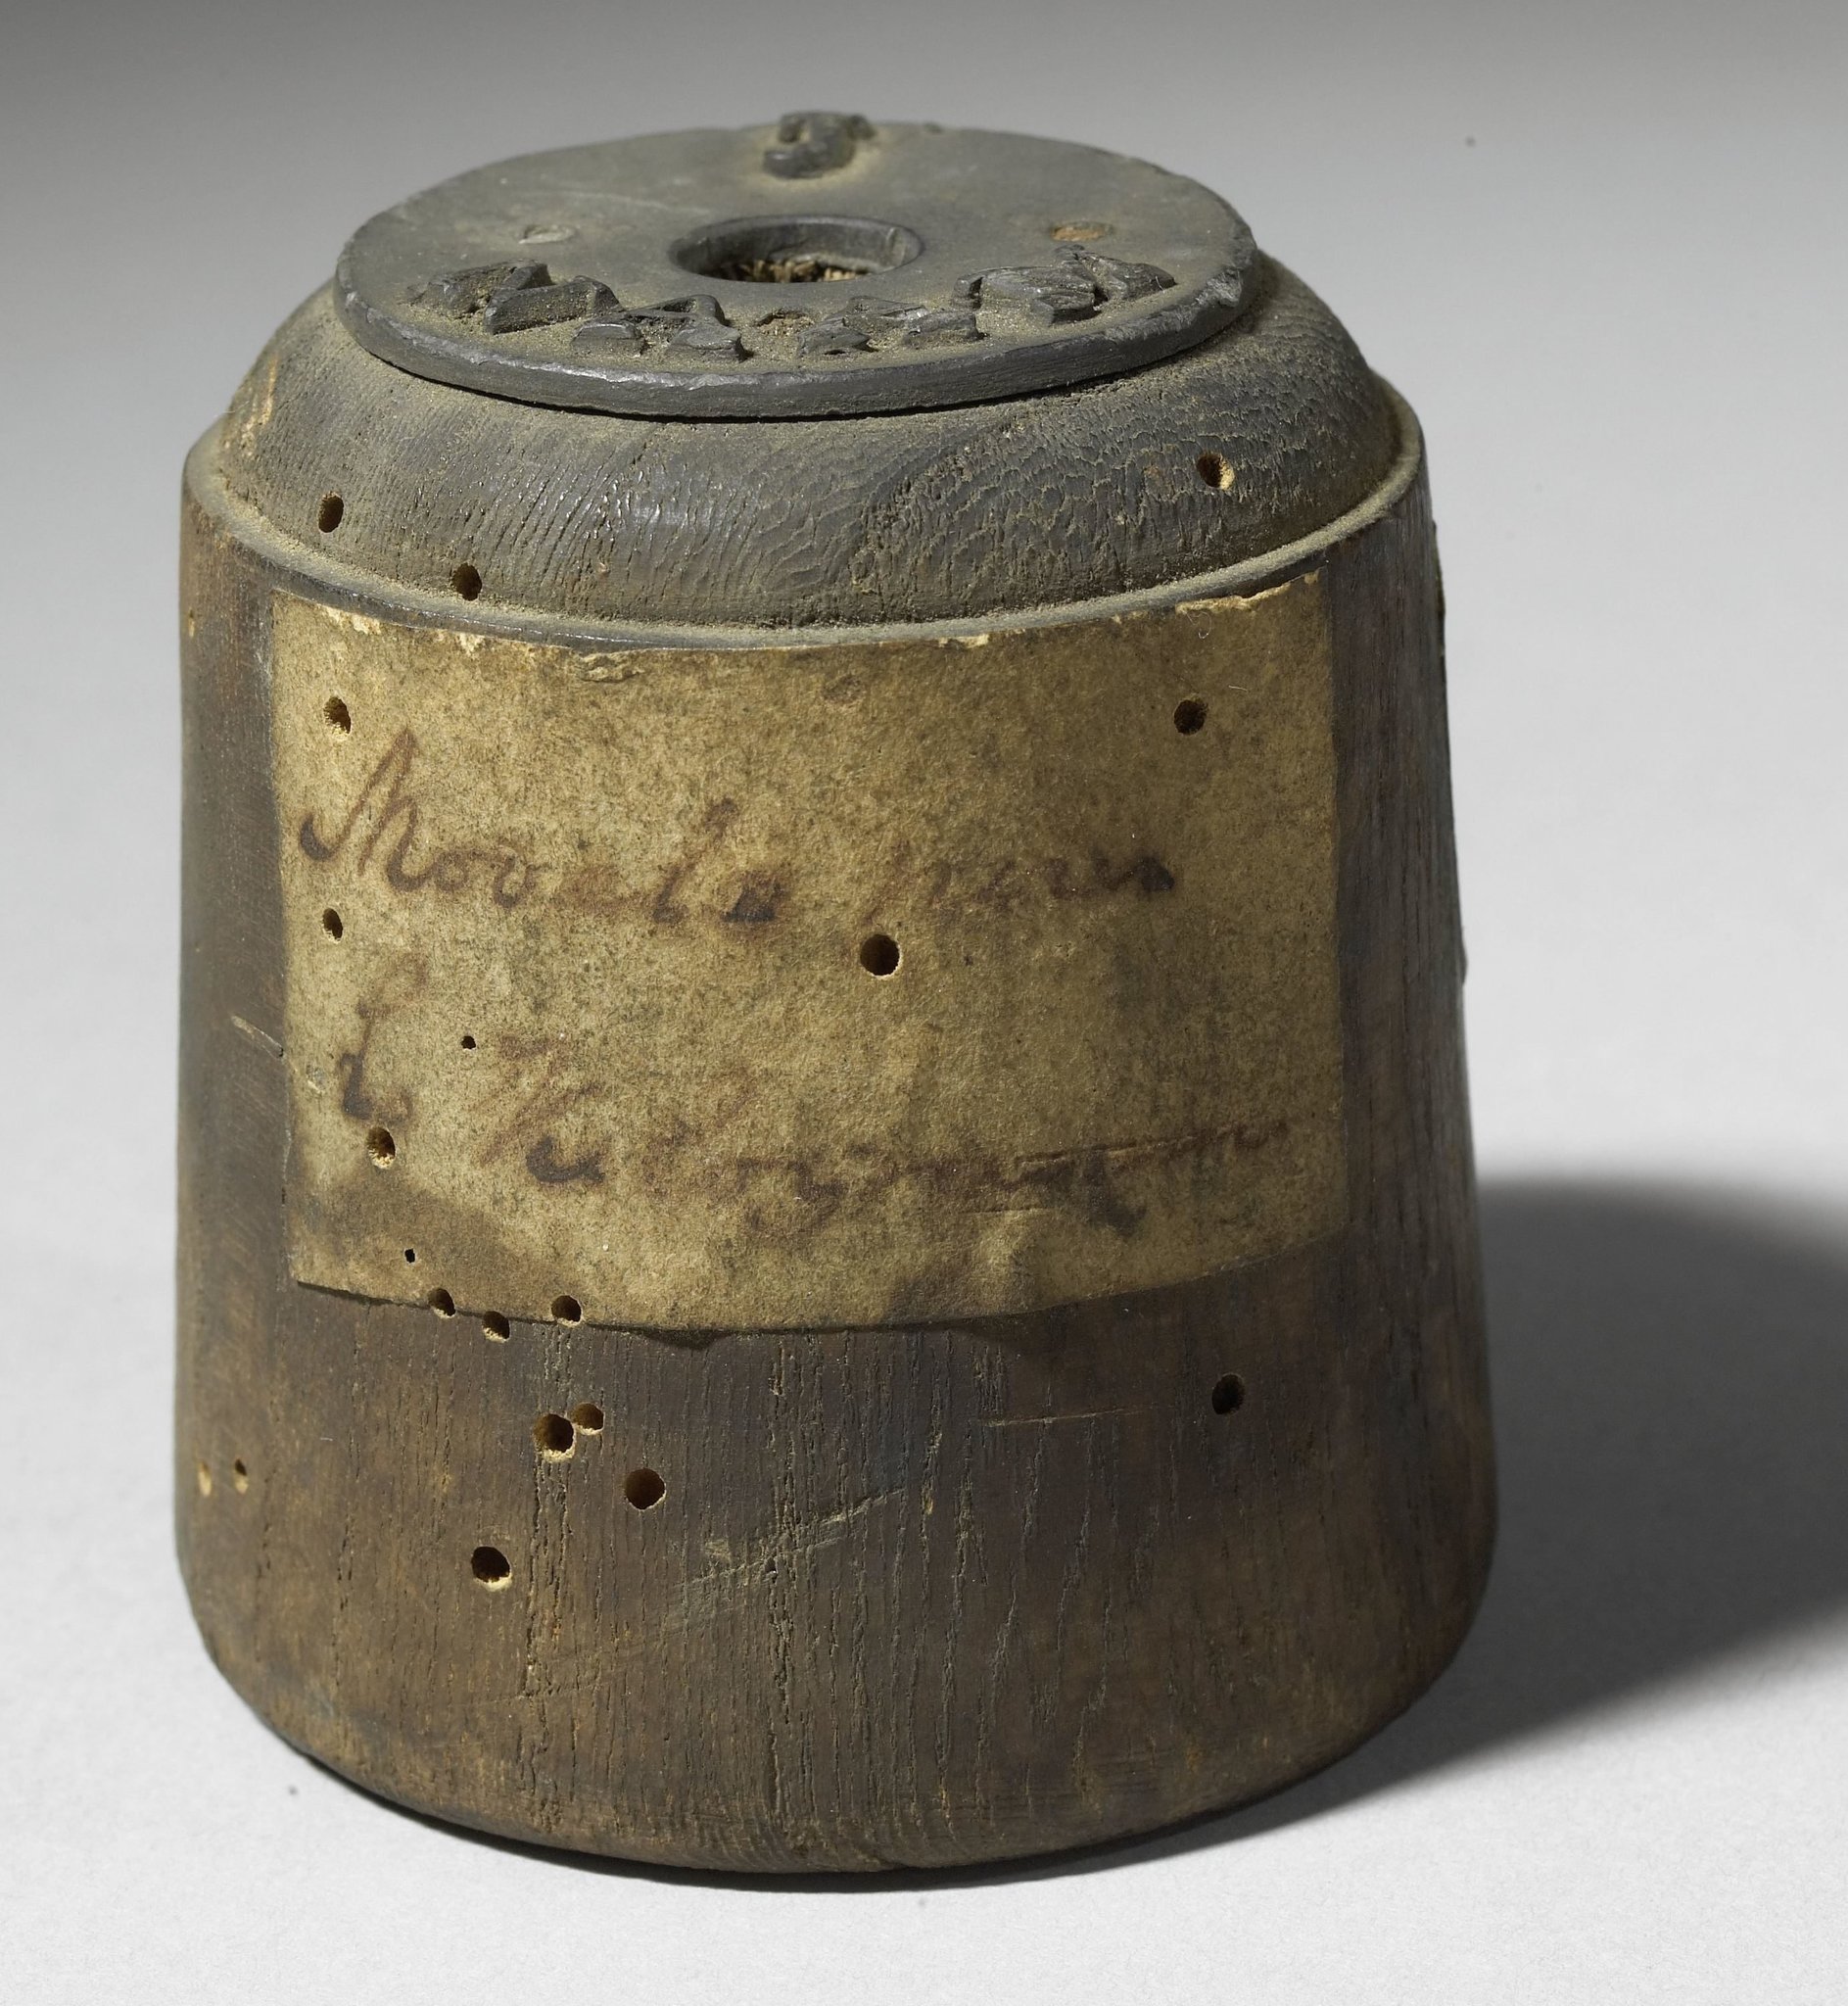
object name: weight scale component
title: Model van 1 kilogram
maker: Anonymous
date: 1830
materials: wood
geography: netherlands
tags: netherlands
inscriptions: title: ‘Model van 1 kilogram...’, : ‘J NAAM’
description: Gietmodel voor een kegelvormig gewicht van 1 kilogram. V.z.v. etiket.